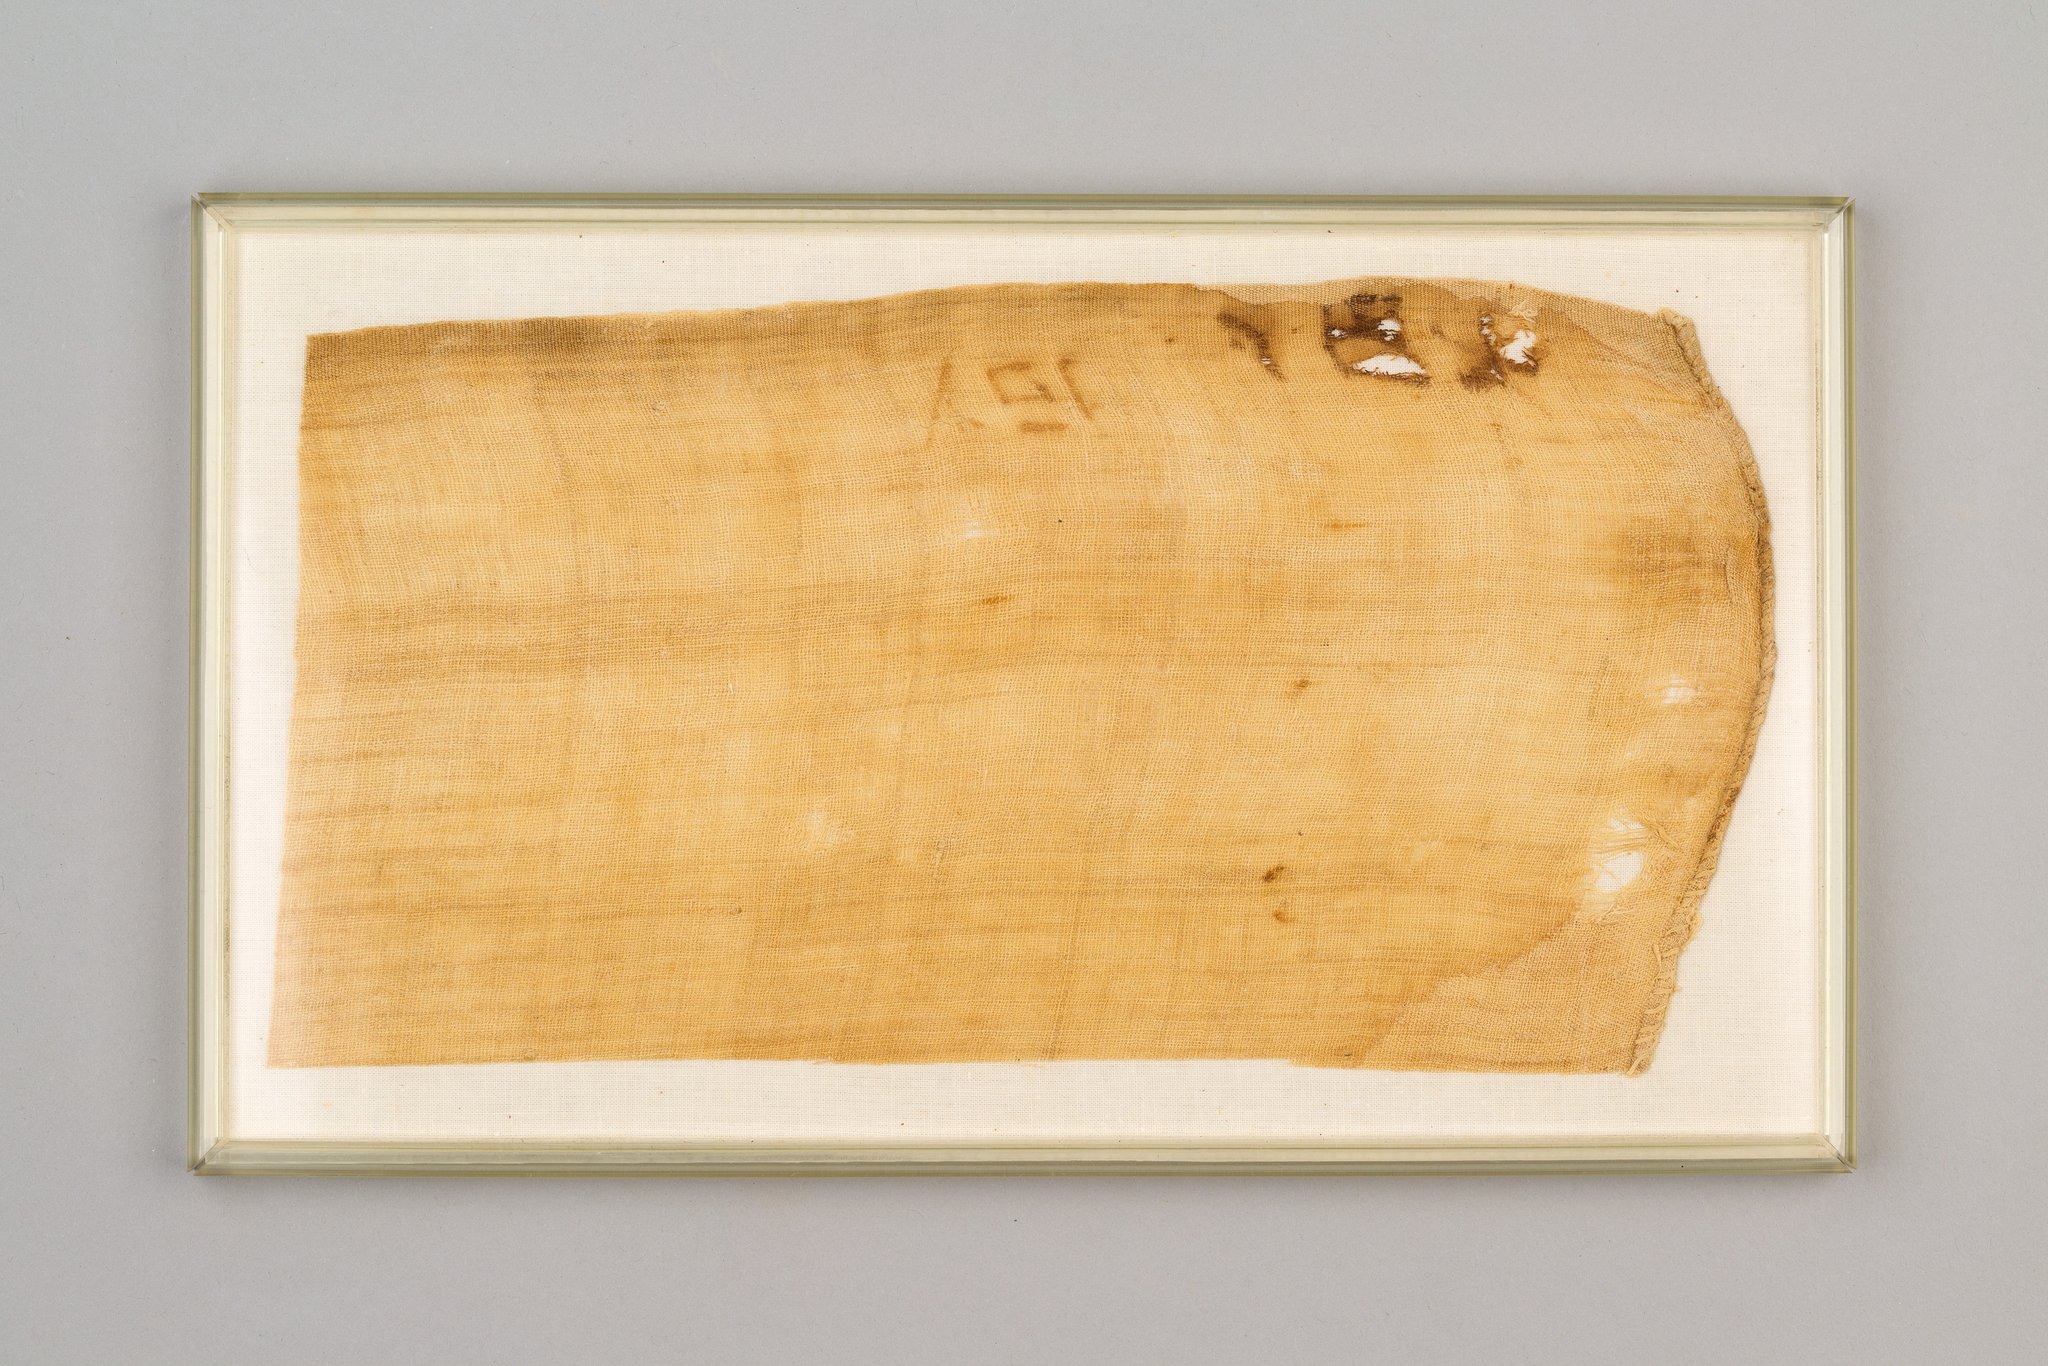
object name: linen mark, wabetamun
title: Linen Mark Recording the Name Wabetamun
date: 1479-1458 BCE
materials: ink, linen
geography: egypt